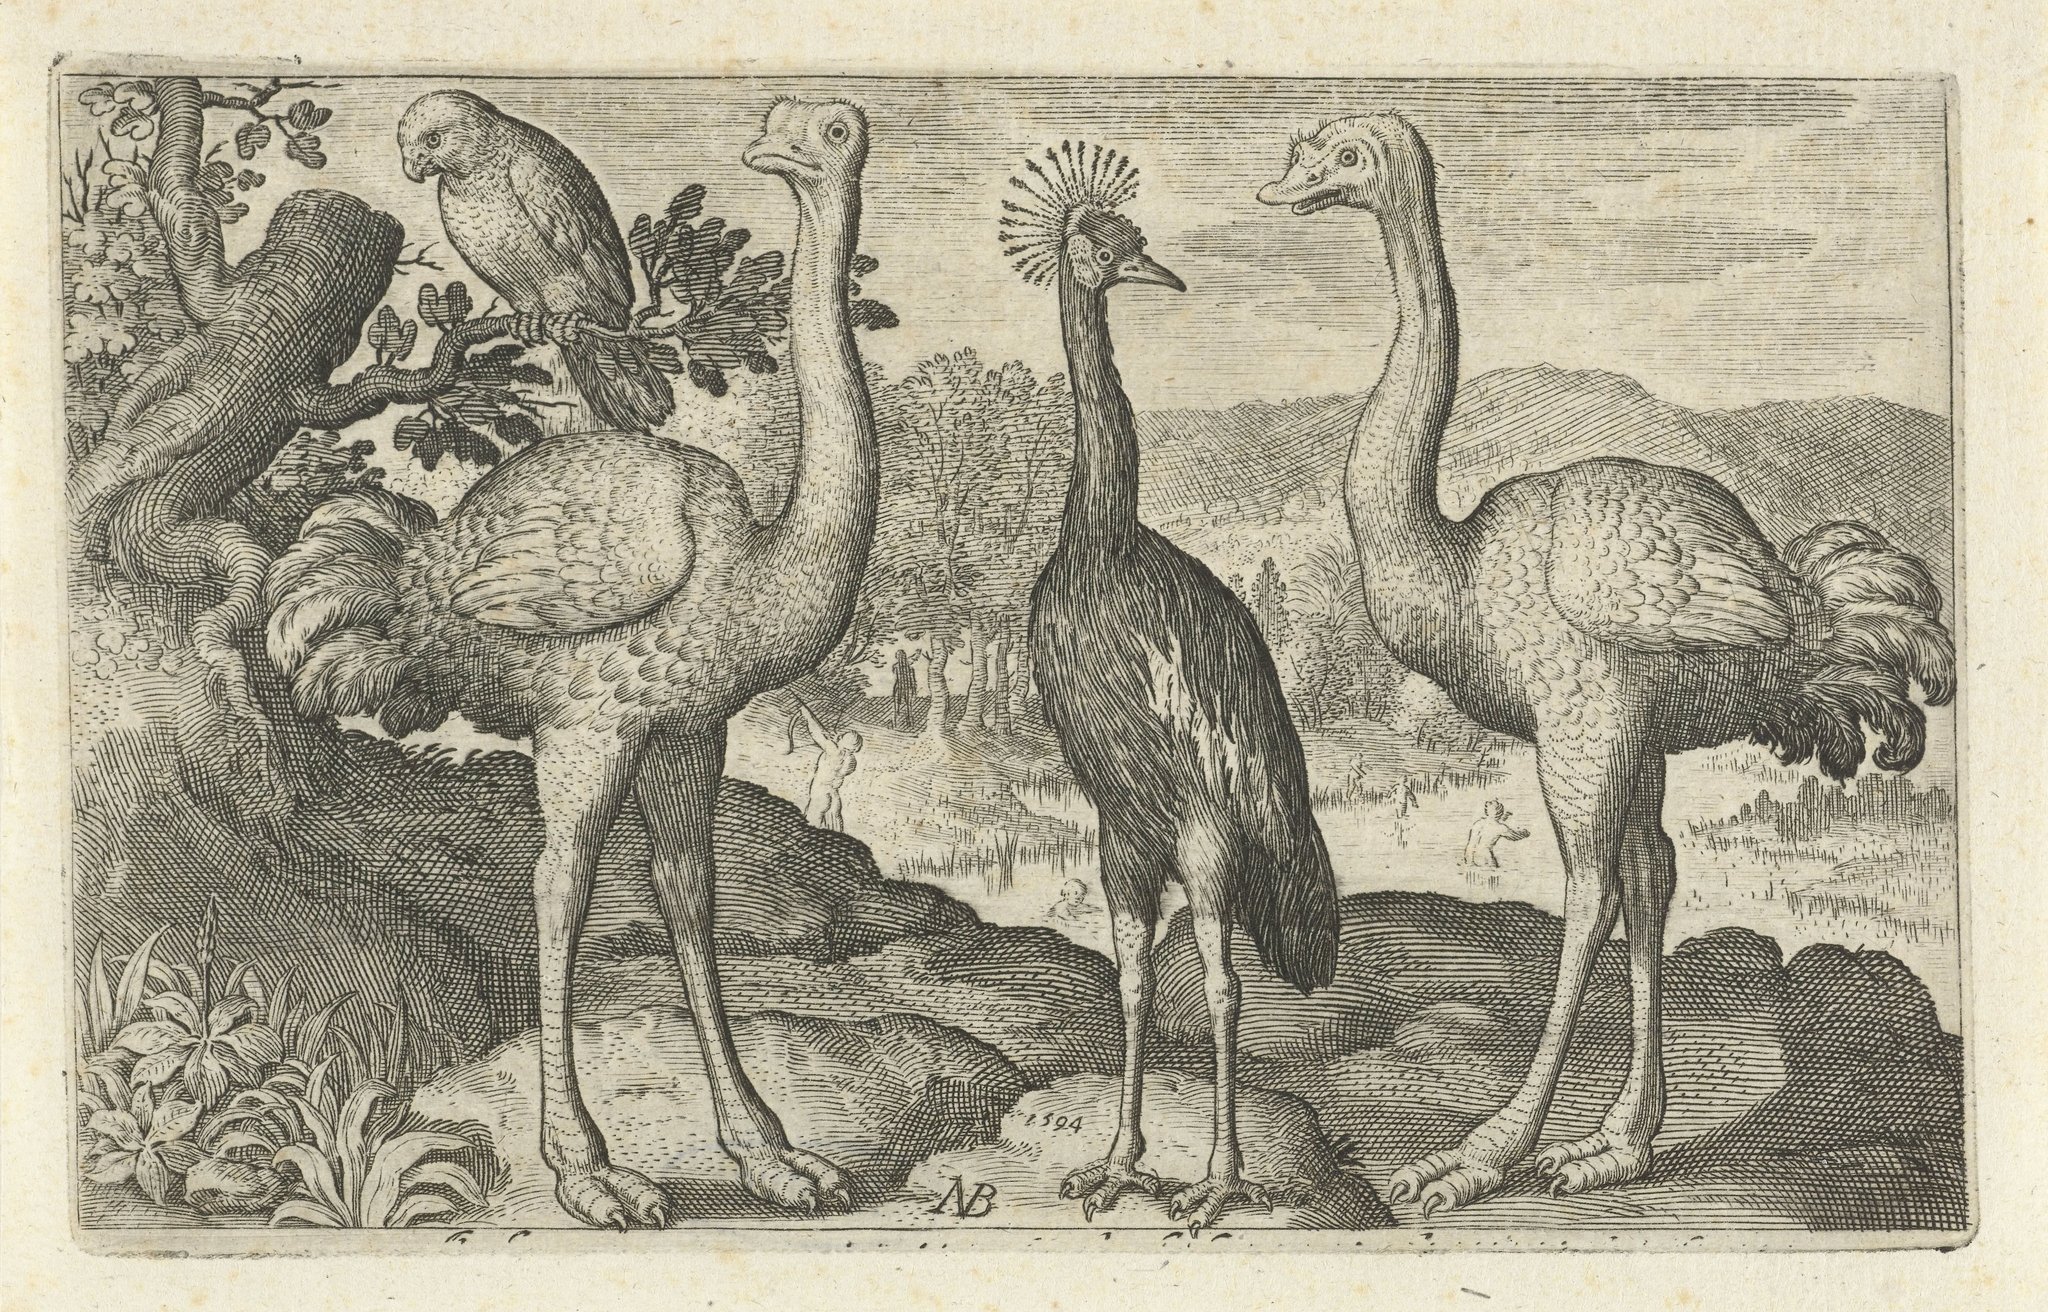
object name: print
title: Vogels en insecten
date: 1594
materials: paper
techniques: engraving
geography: antwerp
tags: shore-birds and wading-birds: crane, walker and runner birds: ostrich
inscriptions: collector's mark: Lugt 2228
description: Prent uit serie van twaalf prenten met vogels en insecten. Bij Hollstein zijn bladen van een andere serie prenten afgebeeld, zie De Groot 1988, p. 37.